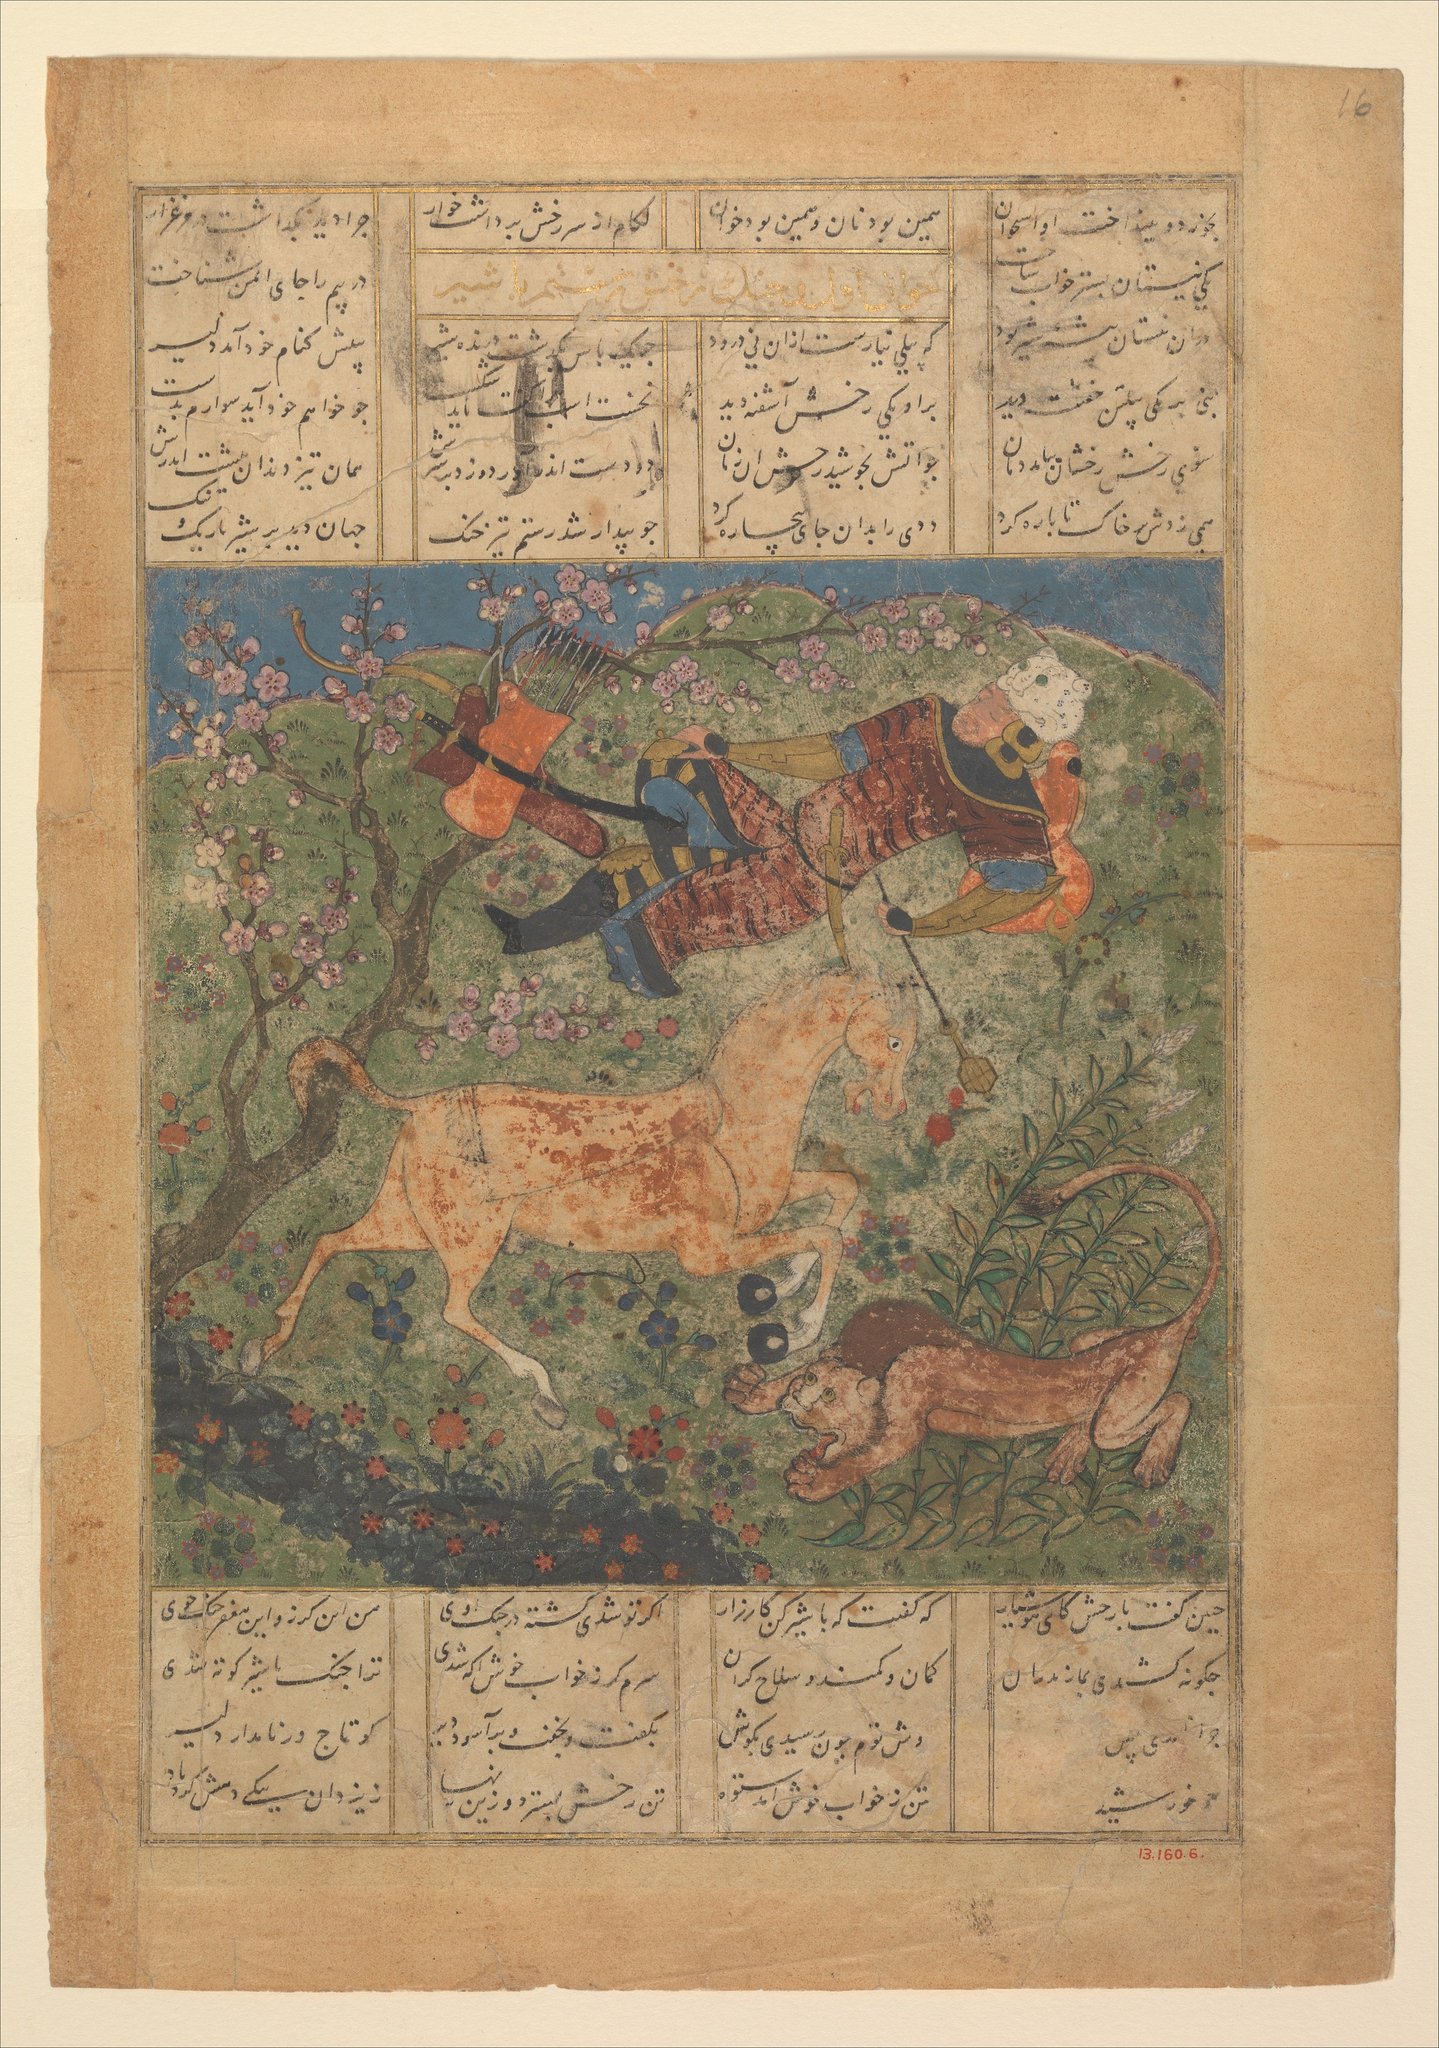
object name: folio from an illustrated manuscript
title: "Rustam Saved by his Horse Rakhsh from an Attacking Lion", Folio from a Shahnama (Book of Kings) of Firdausi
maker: abu'l qasim firdausi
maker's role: author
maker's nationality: iranian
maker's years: 935-1020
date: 1467-1500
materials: gold, ink, paper, watercolor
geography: india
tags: men,horses,lions